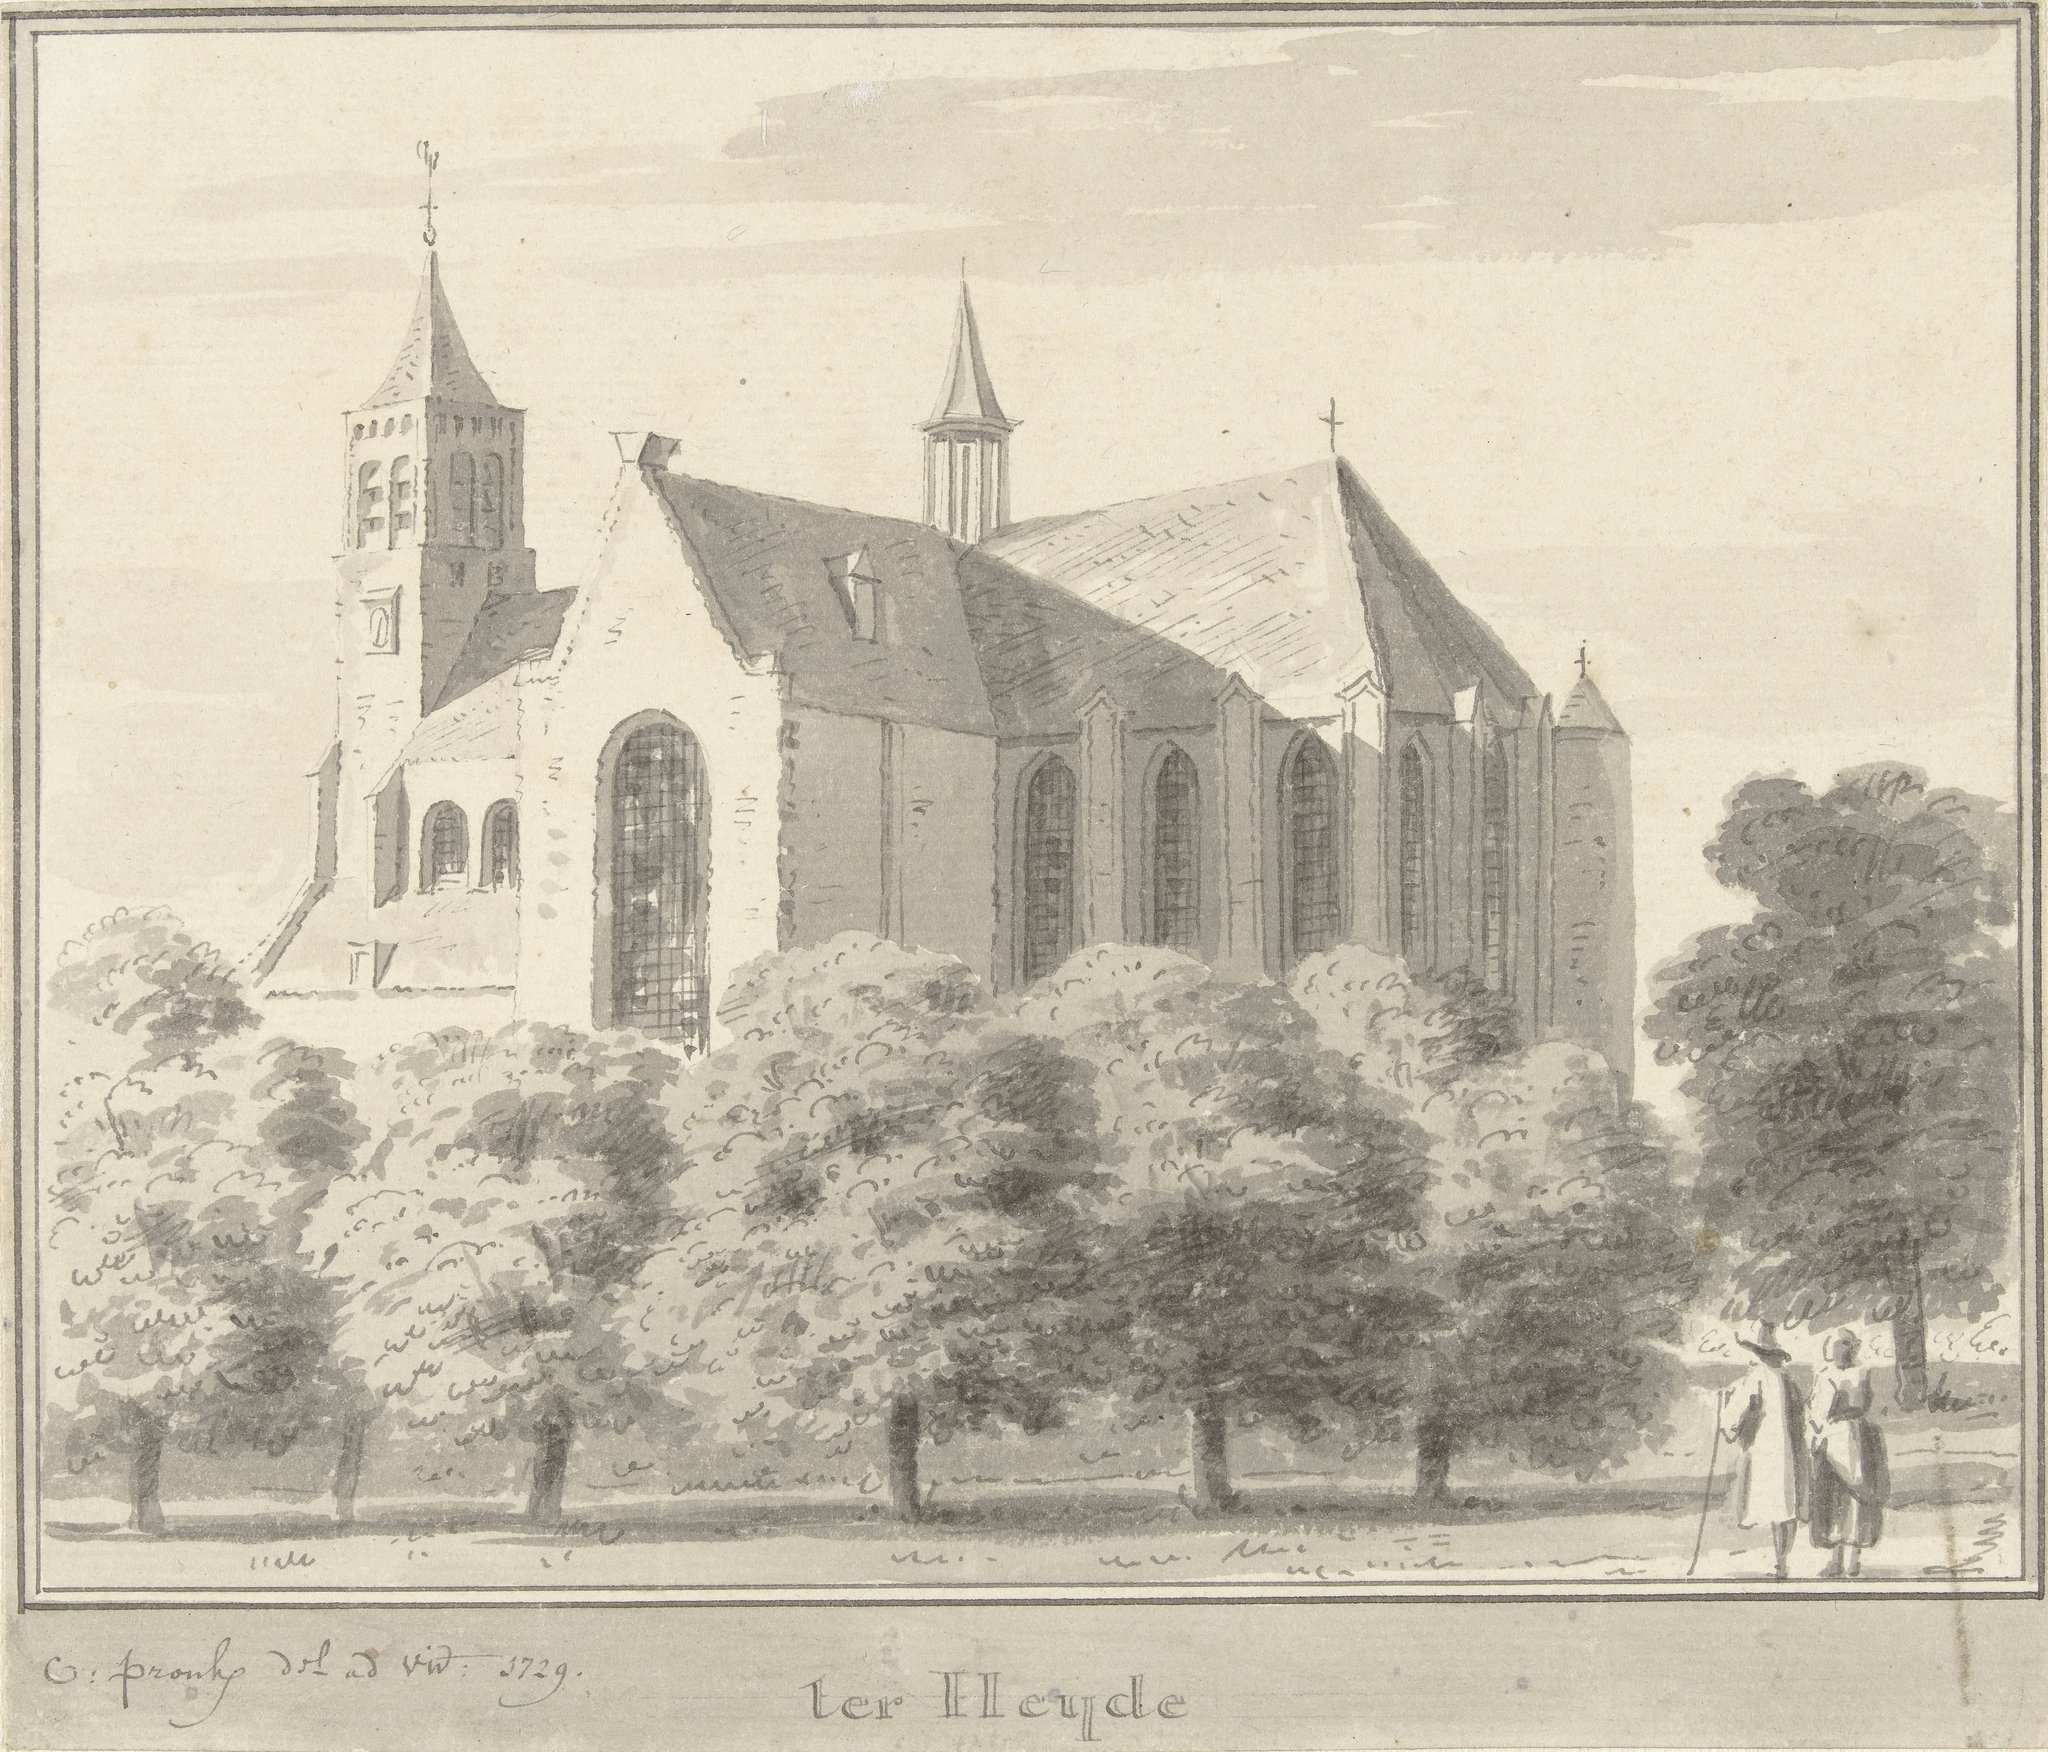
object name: drawing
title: De kerk van Terheijden, Noord Brabant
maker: cornelis pronk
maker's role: draughtsman, painter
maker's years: 1691-1759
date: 1729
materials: ink, paper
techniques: brush, pen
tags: church (exterior)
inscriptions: caption: ‘C: pronk del ad viv 1729. / ter Heyde’